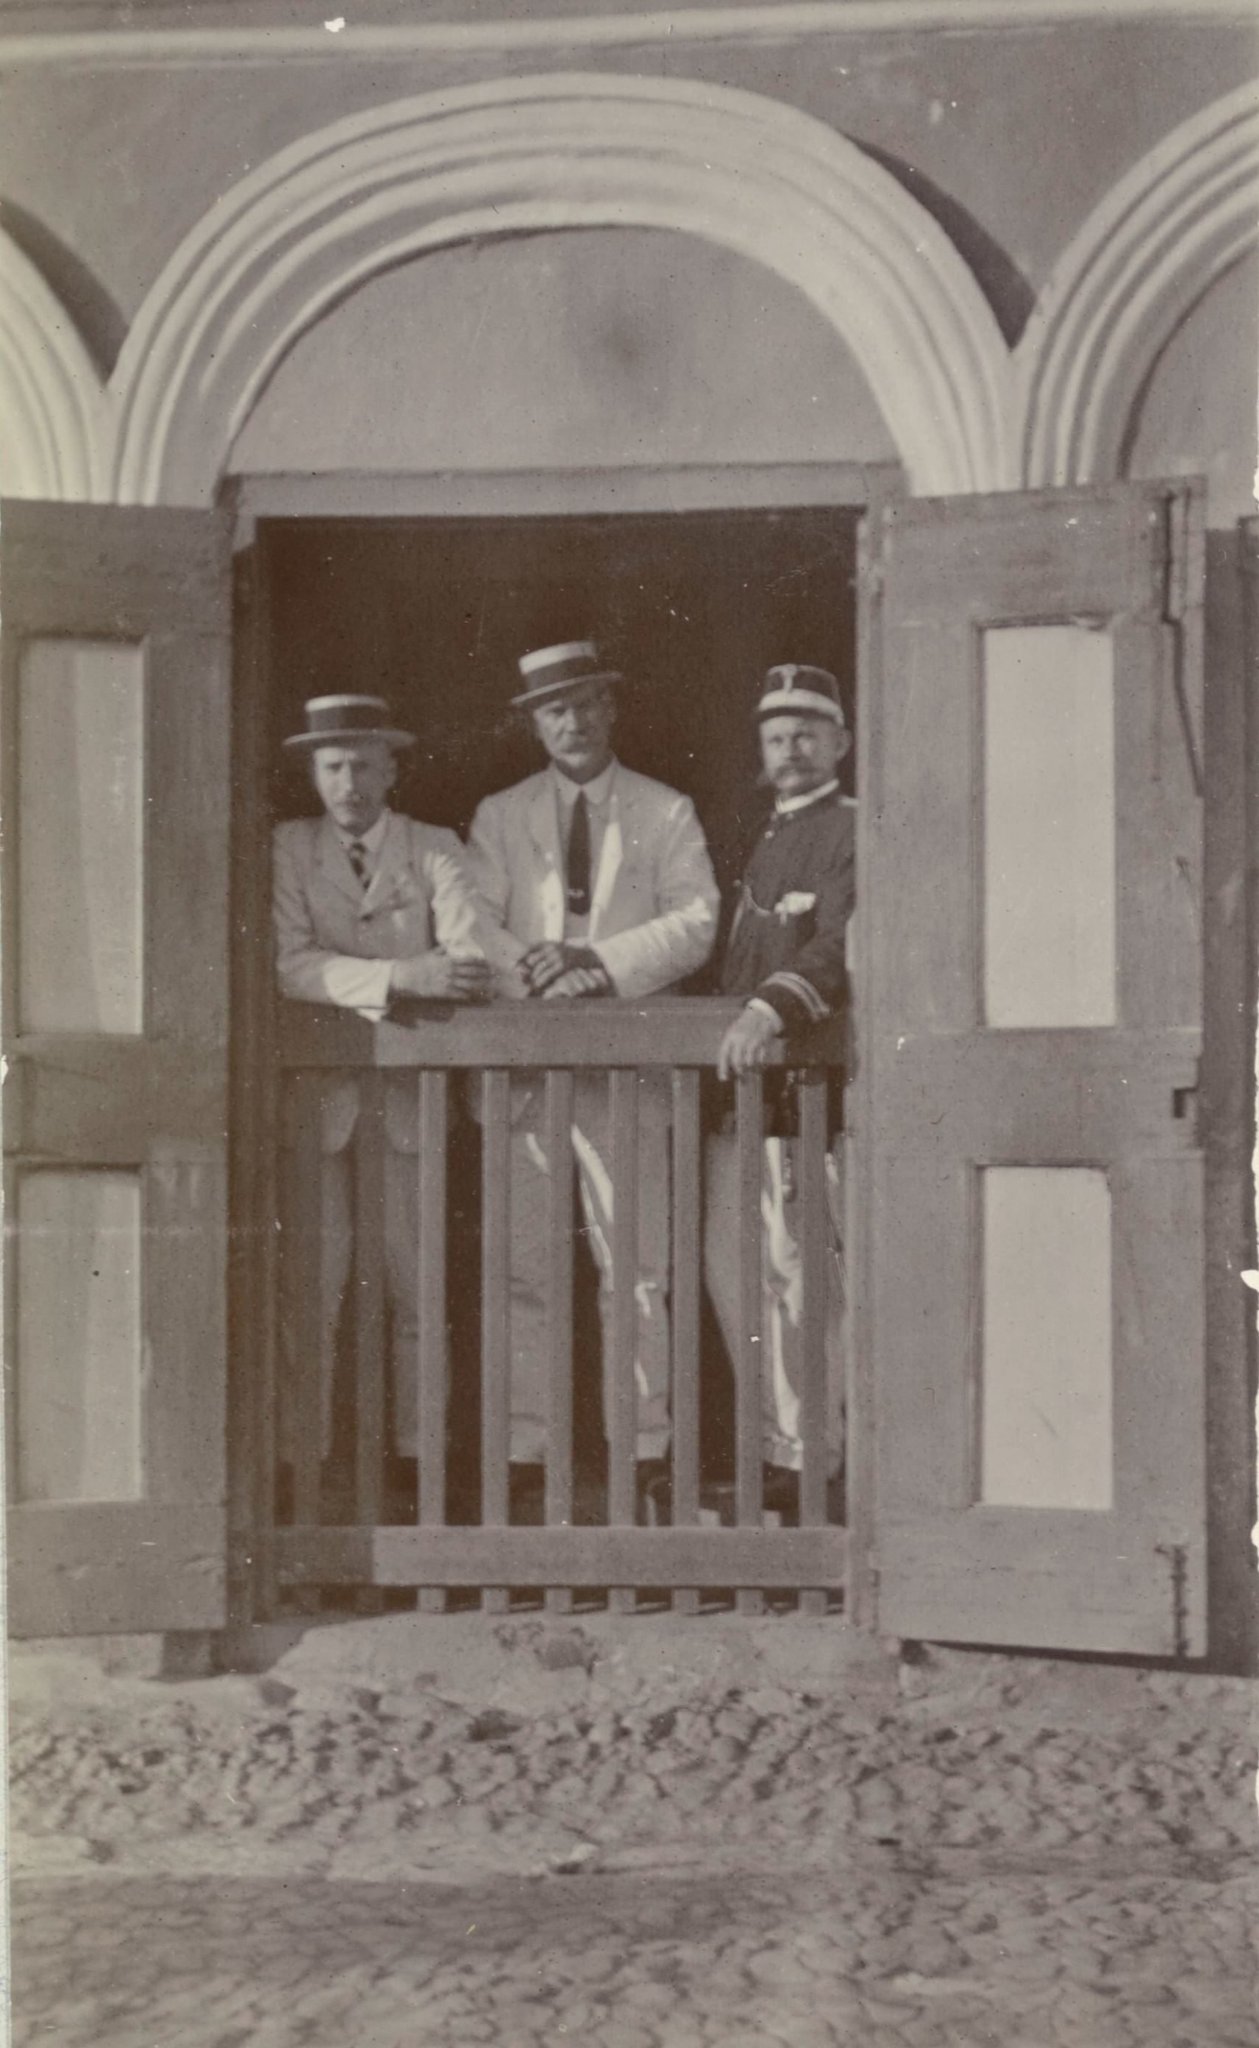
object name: photograph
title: Boom op Curaçao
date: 1908-1910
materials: photographic support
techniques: photography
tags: andries augustus boom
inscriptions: inscription: ‘A.A. Boom / A. Statinus Muller. Agent v/d K.W.I.M. ... Aug. 1910 Curaçao.’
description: Andries Boom poserend met de plaatselijke agent van de K.W.I.M. en de commandant van de politie, augustus 1910 Curaçao. Onderdeel van het fotoalbum van de familie Boom-Gonggrijp in Suriname en Curaçao.